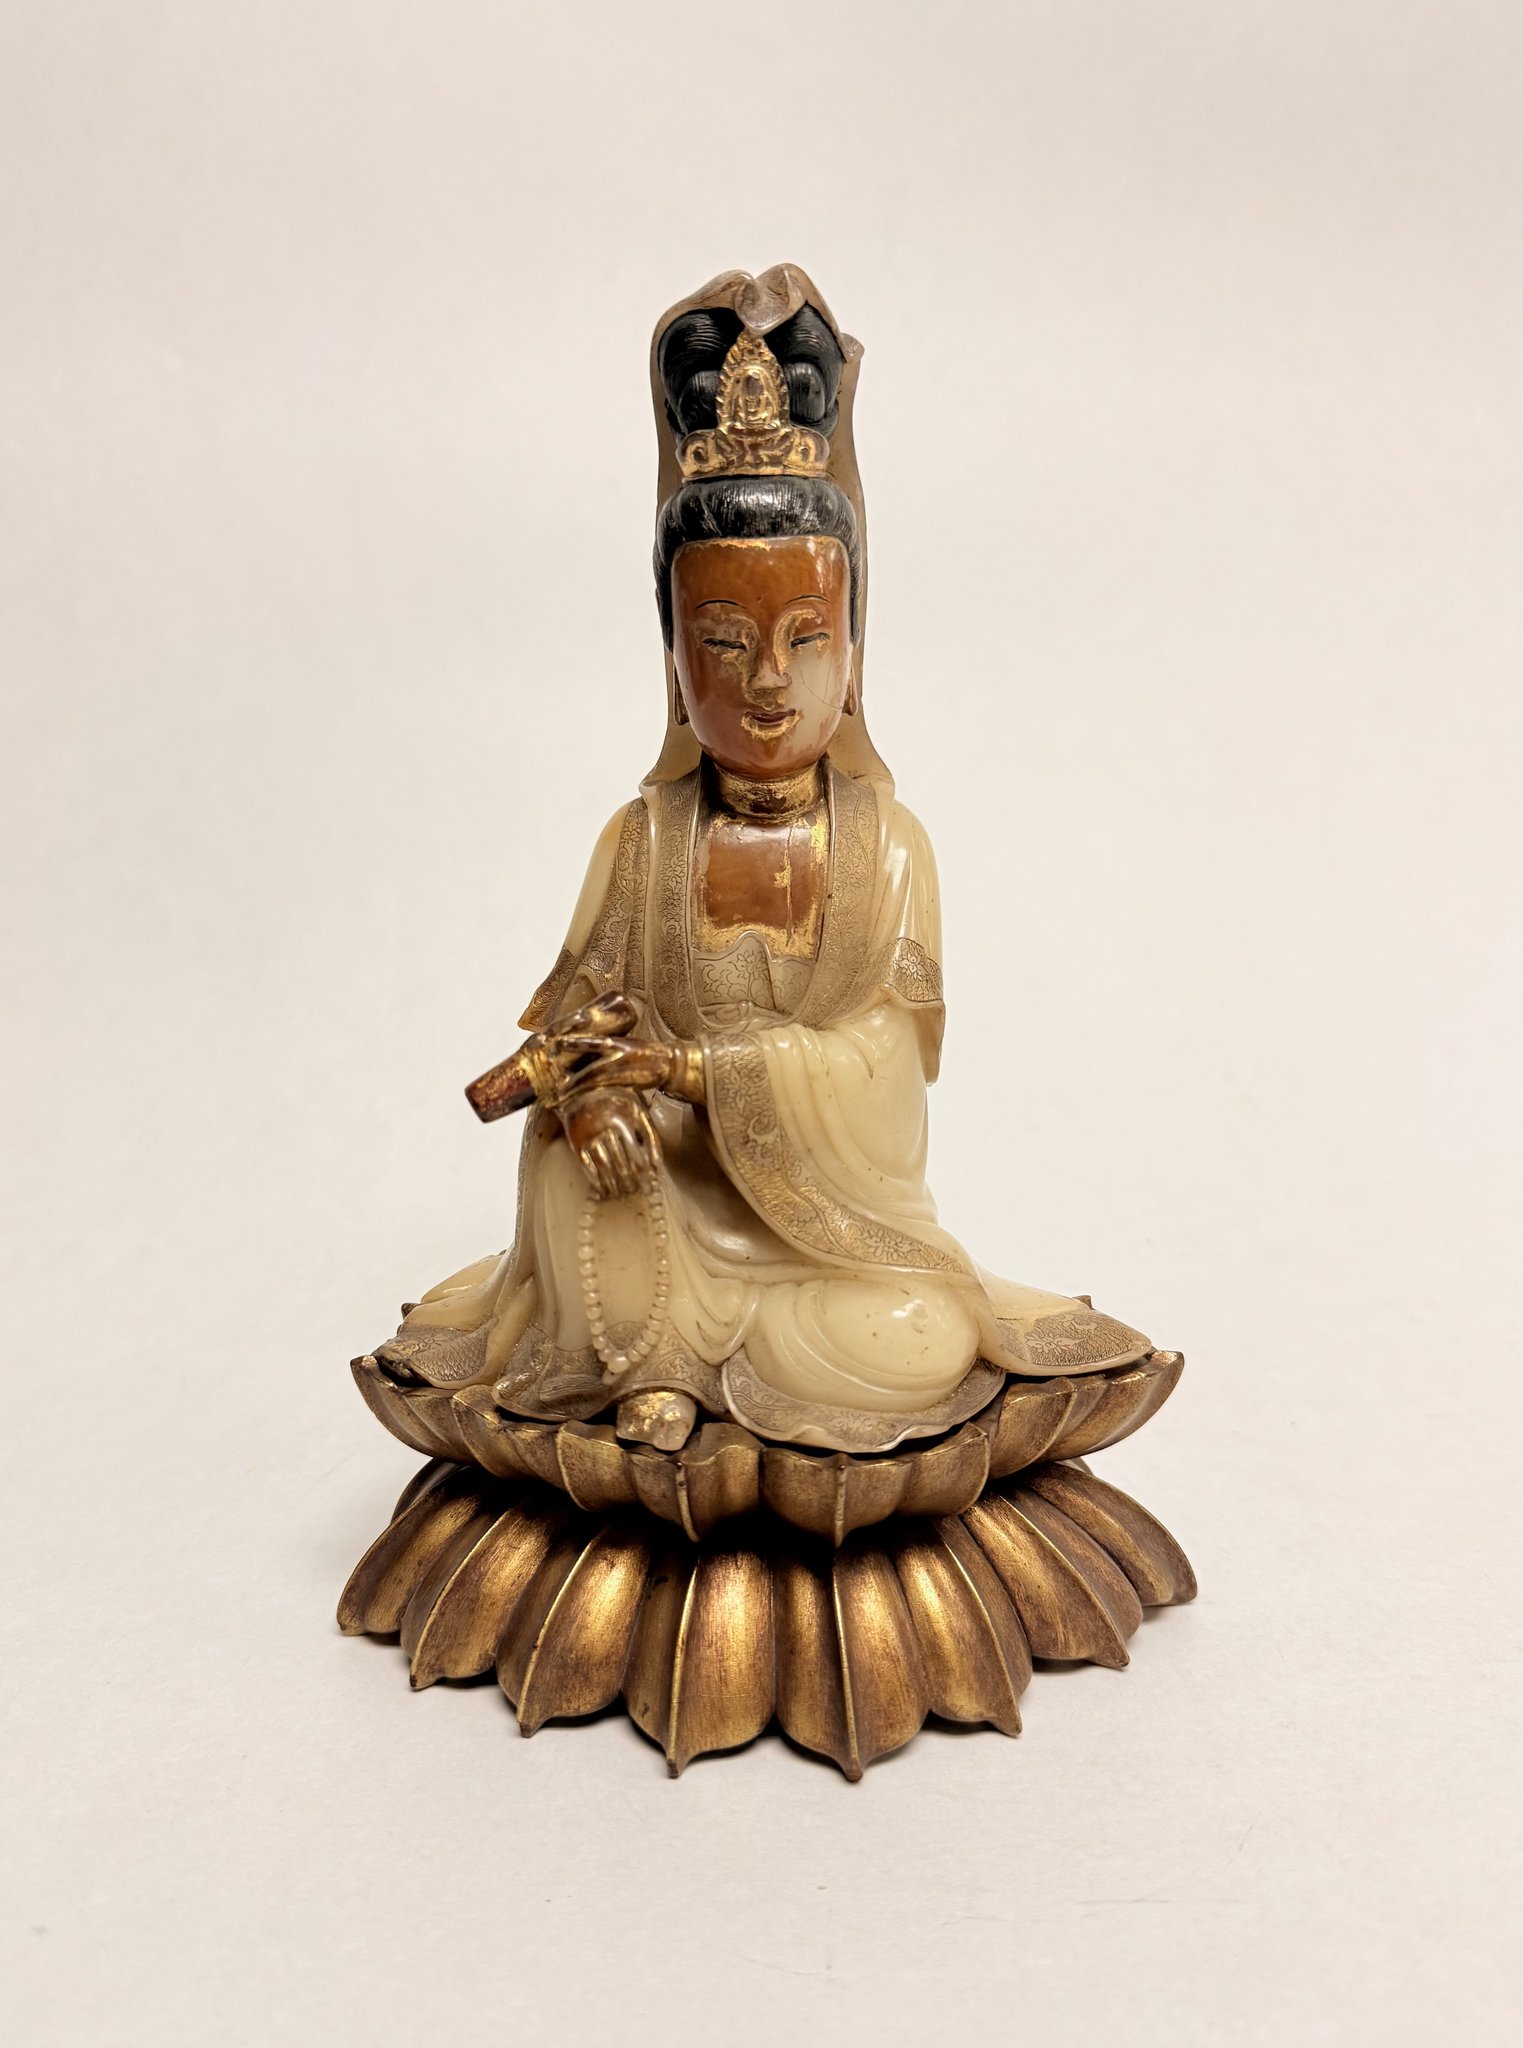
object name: figure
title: Guanyin Figure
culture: chinese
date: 1701-1800